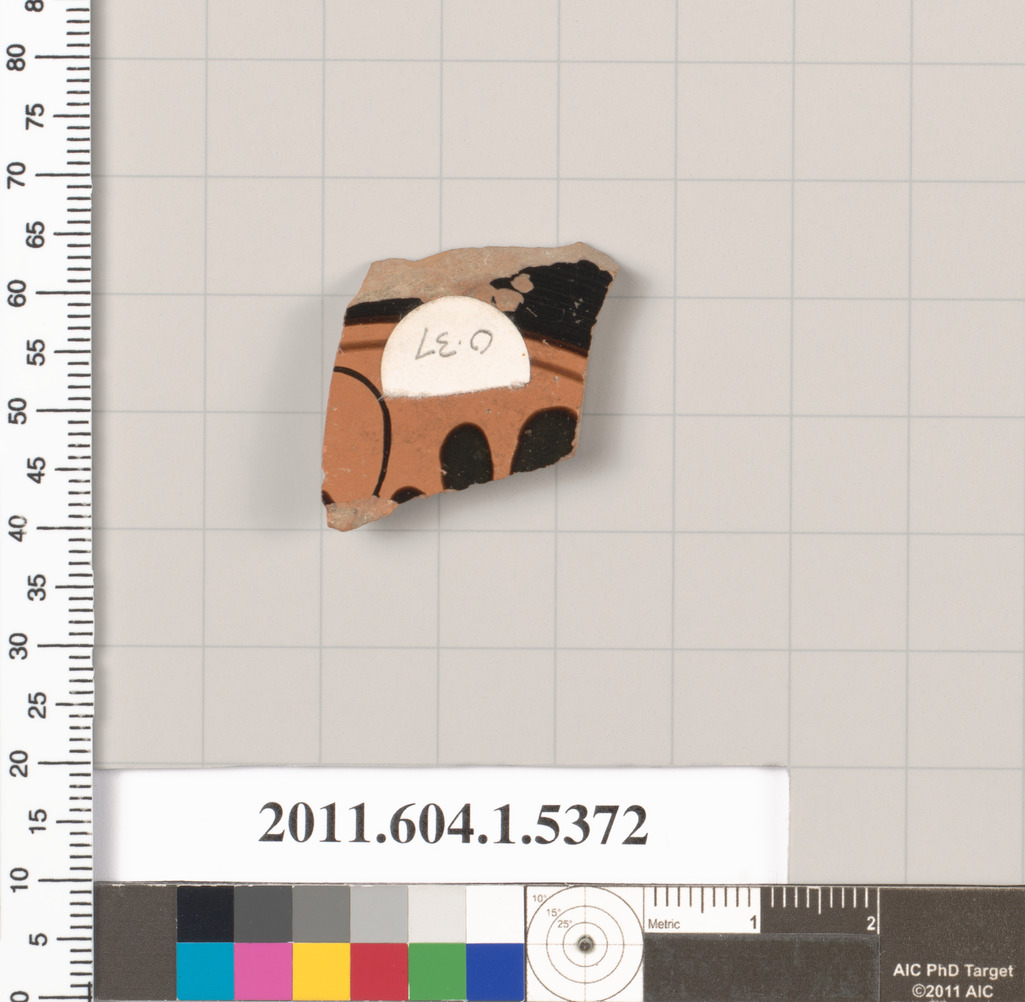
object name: kylix fragment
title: Terracotta fragment of a kylix (drinking cup)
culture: greek, attic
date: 500-480 BCE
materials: terracotta